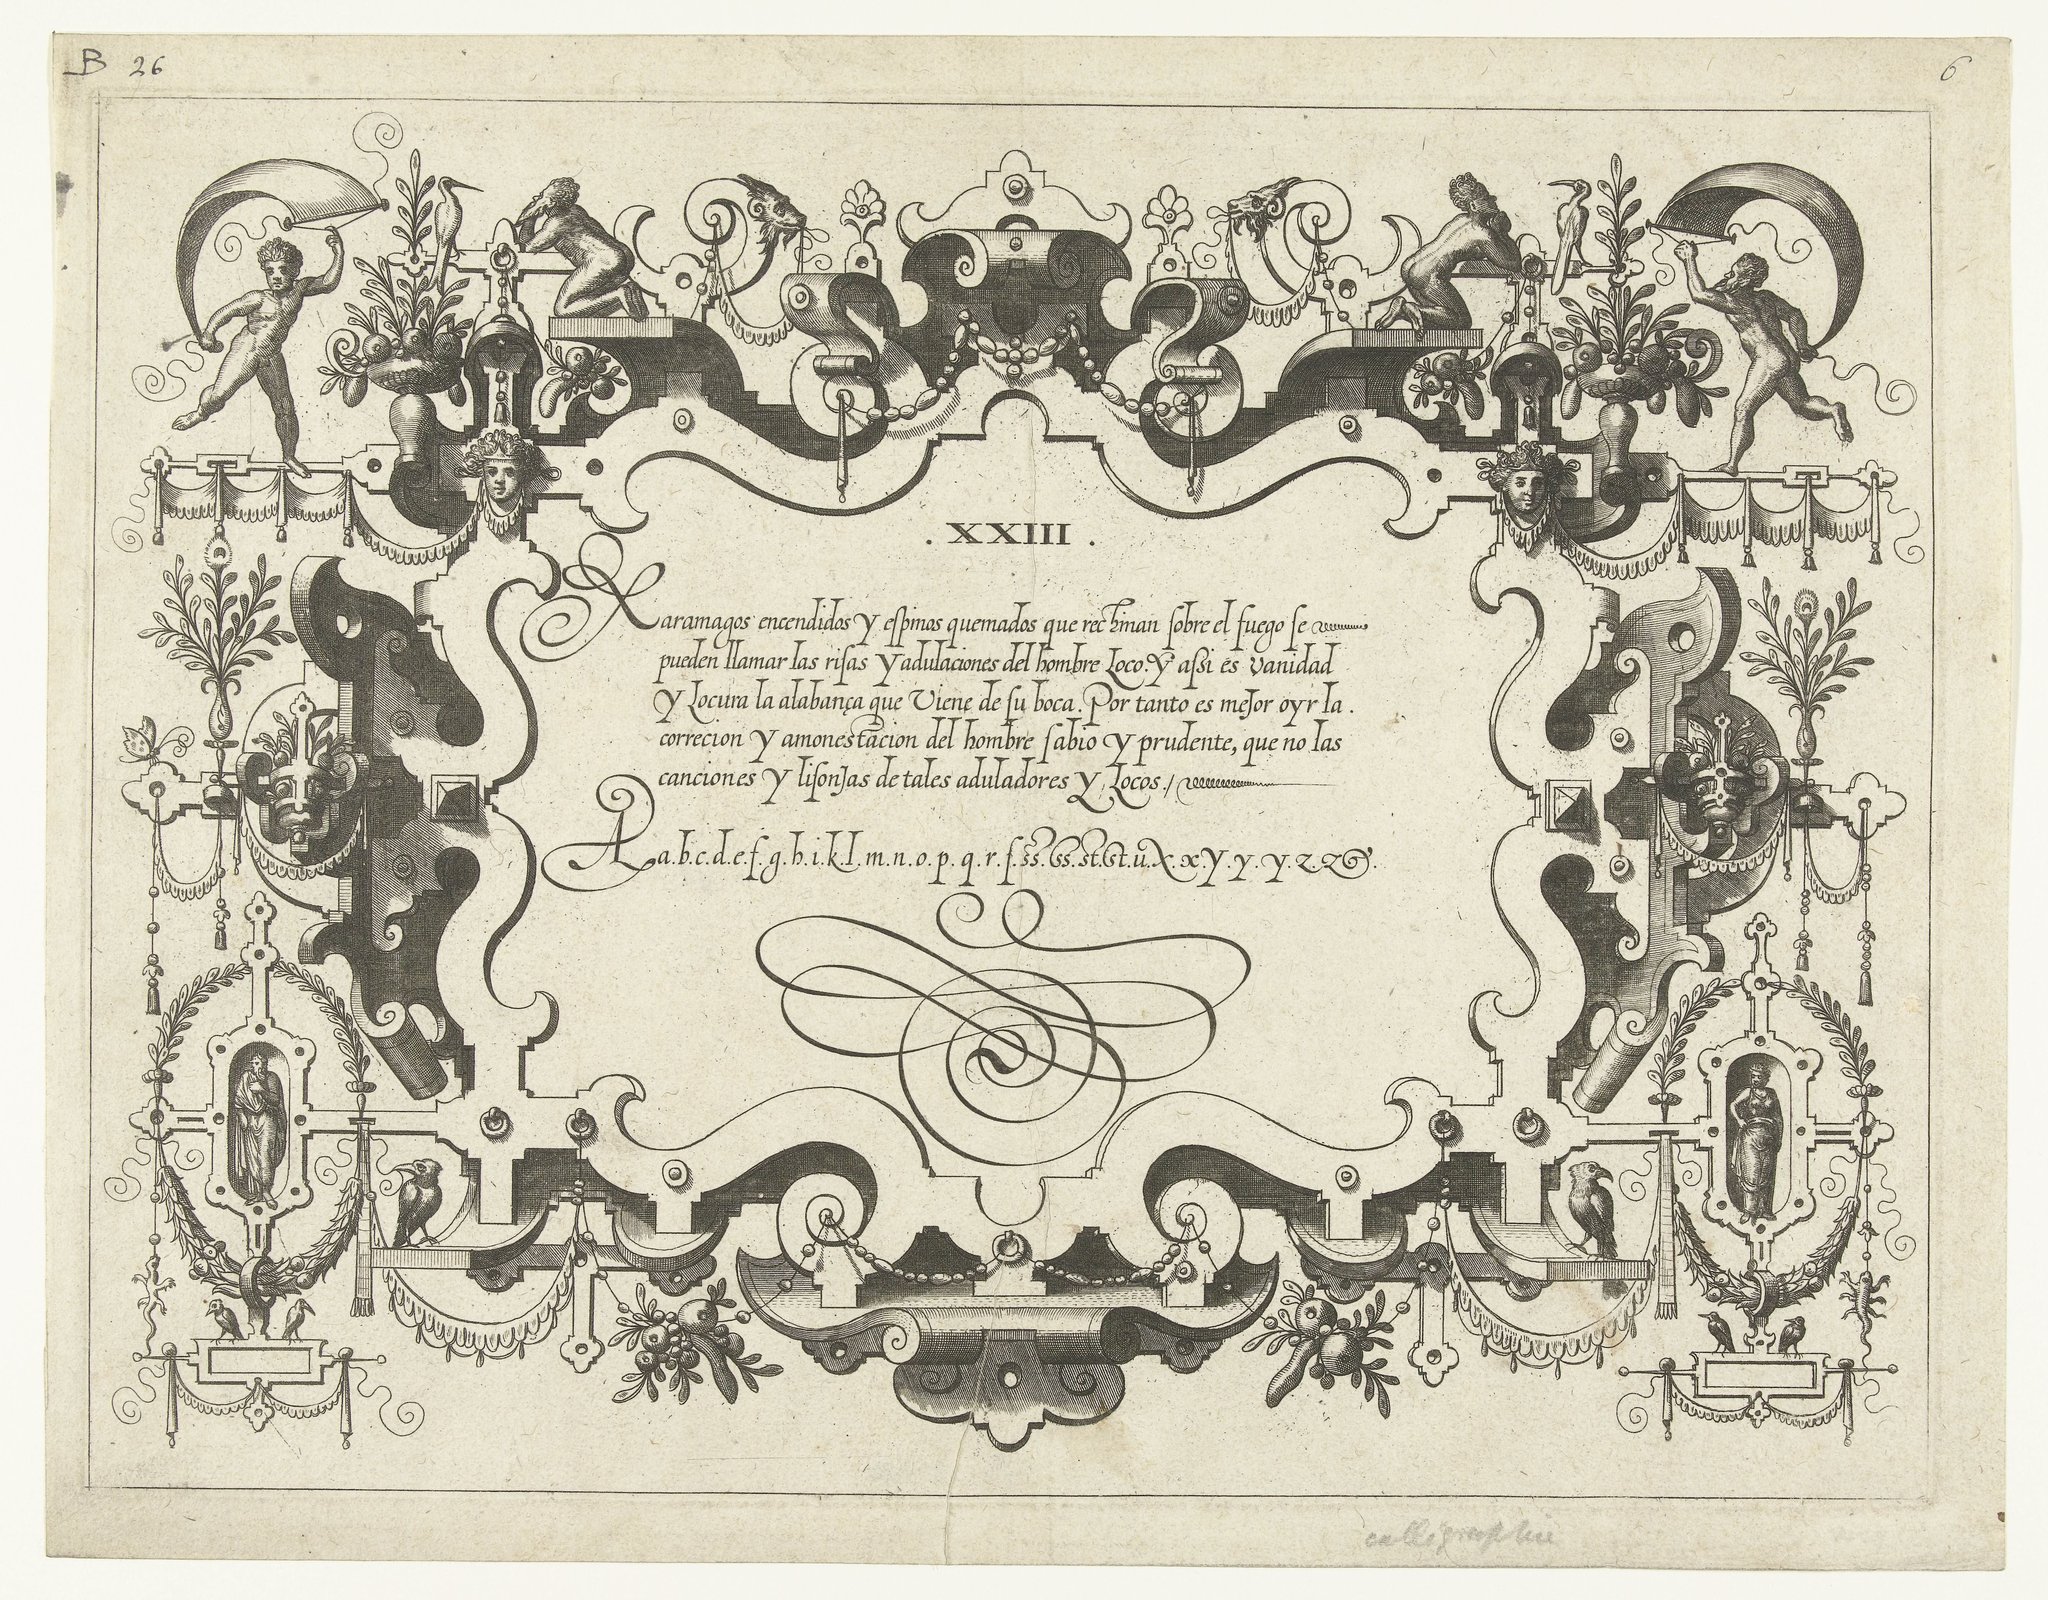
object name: print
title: Cartouche met kalligrafie, links- en rechtsboven een man met vaandel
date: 1569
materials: paper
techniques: engraving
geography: netherlands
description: Blad XXIII. Cartouche met de tekst Xaramagos encendidos y espinos.... Linksonder en rechtsonder hangt een krans van bladeren om een nis in het beslagwerk. In de linker nis staat een man, in de rechter een vrouw. Uit serie van 21 genummerde cartouches met kalligrafie in een omlijsting van rol- en beslagwerk met grotesken, guirlandes en mascarons.